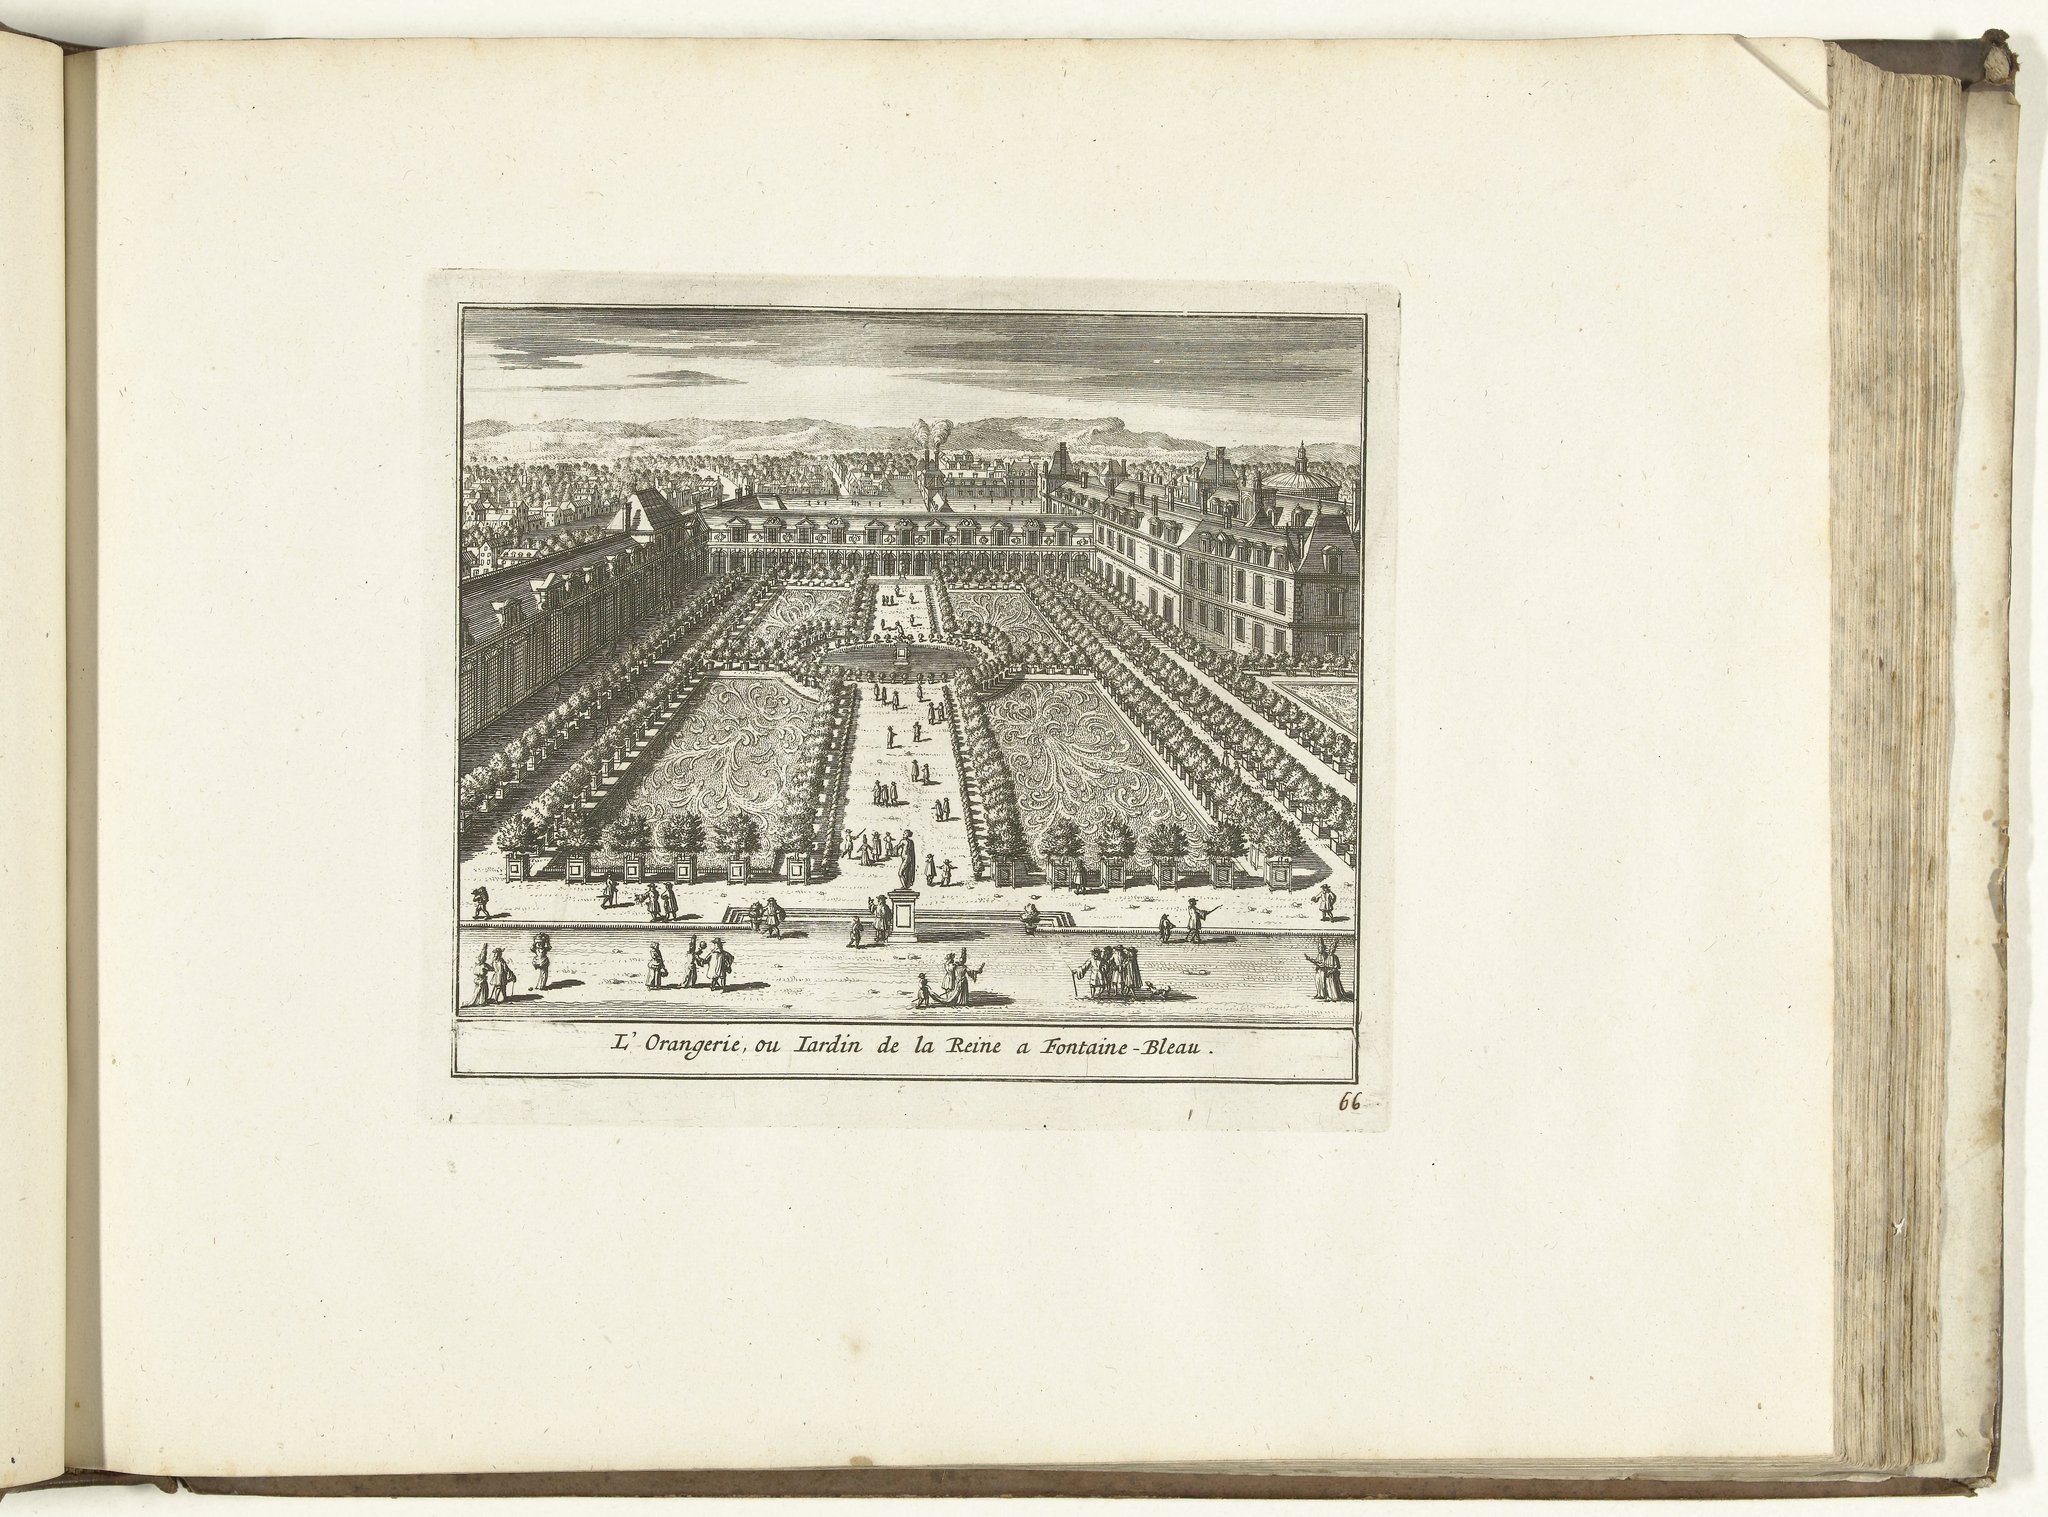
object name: print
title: Gezicht op de Orangerie en Cour de la Fontaine in het paleis van Fontainebleau, 1726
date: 1726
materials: paper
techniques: etching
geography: northern netherlands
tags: palace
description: Gezicht op de Orangerie en de Jardin de la Reine in het paleis van Fontainebleau. Plaat nr. 66 in deel III van het prentwerk: Les Forces de l'Europe, Asie, Afrique et Amerique ... Comme aussi les Cartes des Côtes de France et d'Espagne uit 1726, dit eerste deel met 238 met de hand genummerde platen van vermaarde sterke steden en vestingen in het kader van de Spaanse Successieoorlog 1701-1713. Voor het merendeel zijn deze platen gekopieerd naar de anonieme Franse platen van vermaarde sterke steden en vestingen: in Les forces de l'Europe en in: Le theatre de la guerre, dans les Pays-Bas, beide oorspronkelijk uitgegeven door Nicolas de Fer te Parijs (1693-1697) in het kader van de Negenjarige Oorlog. Titel in het Frans.